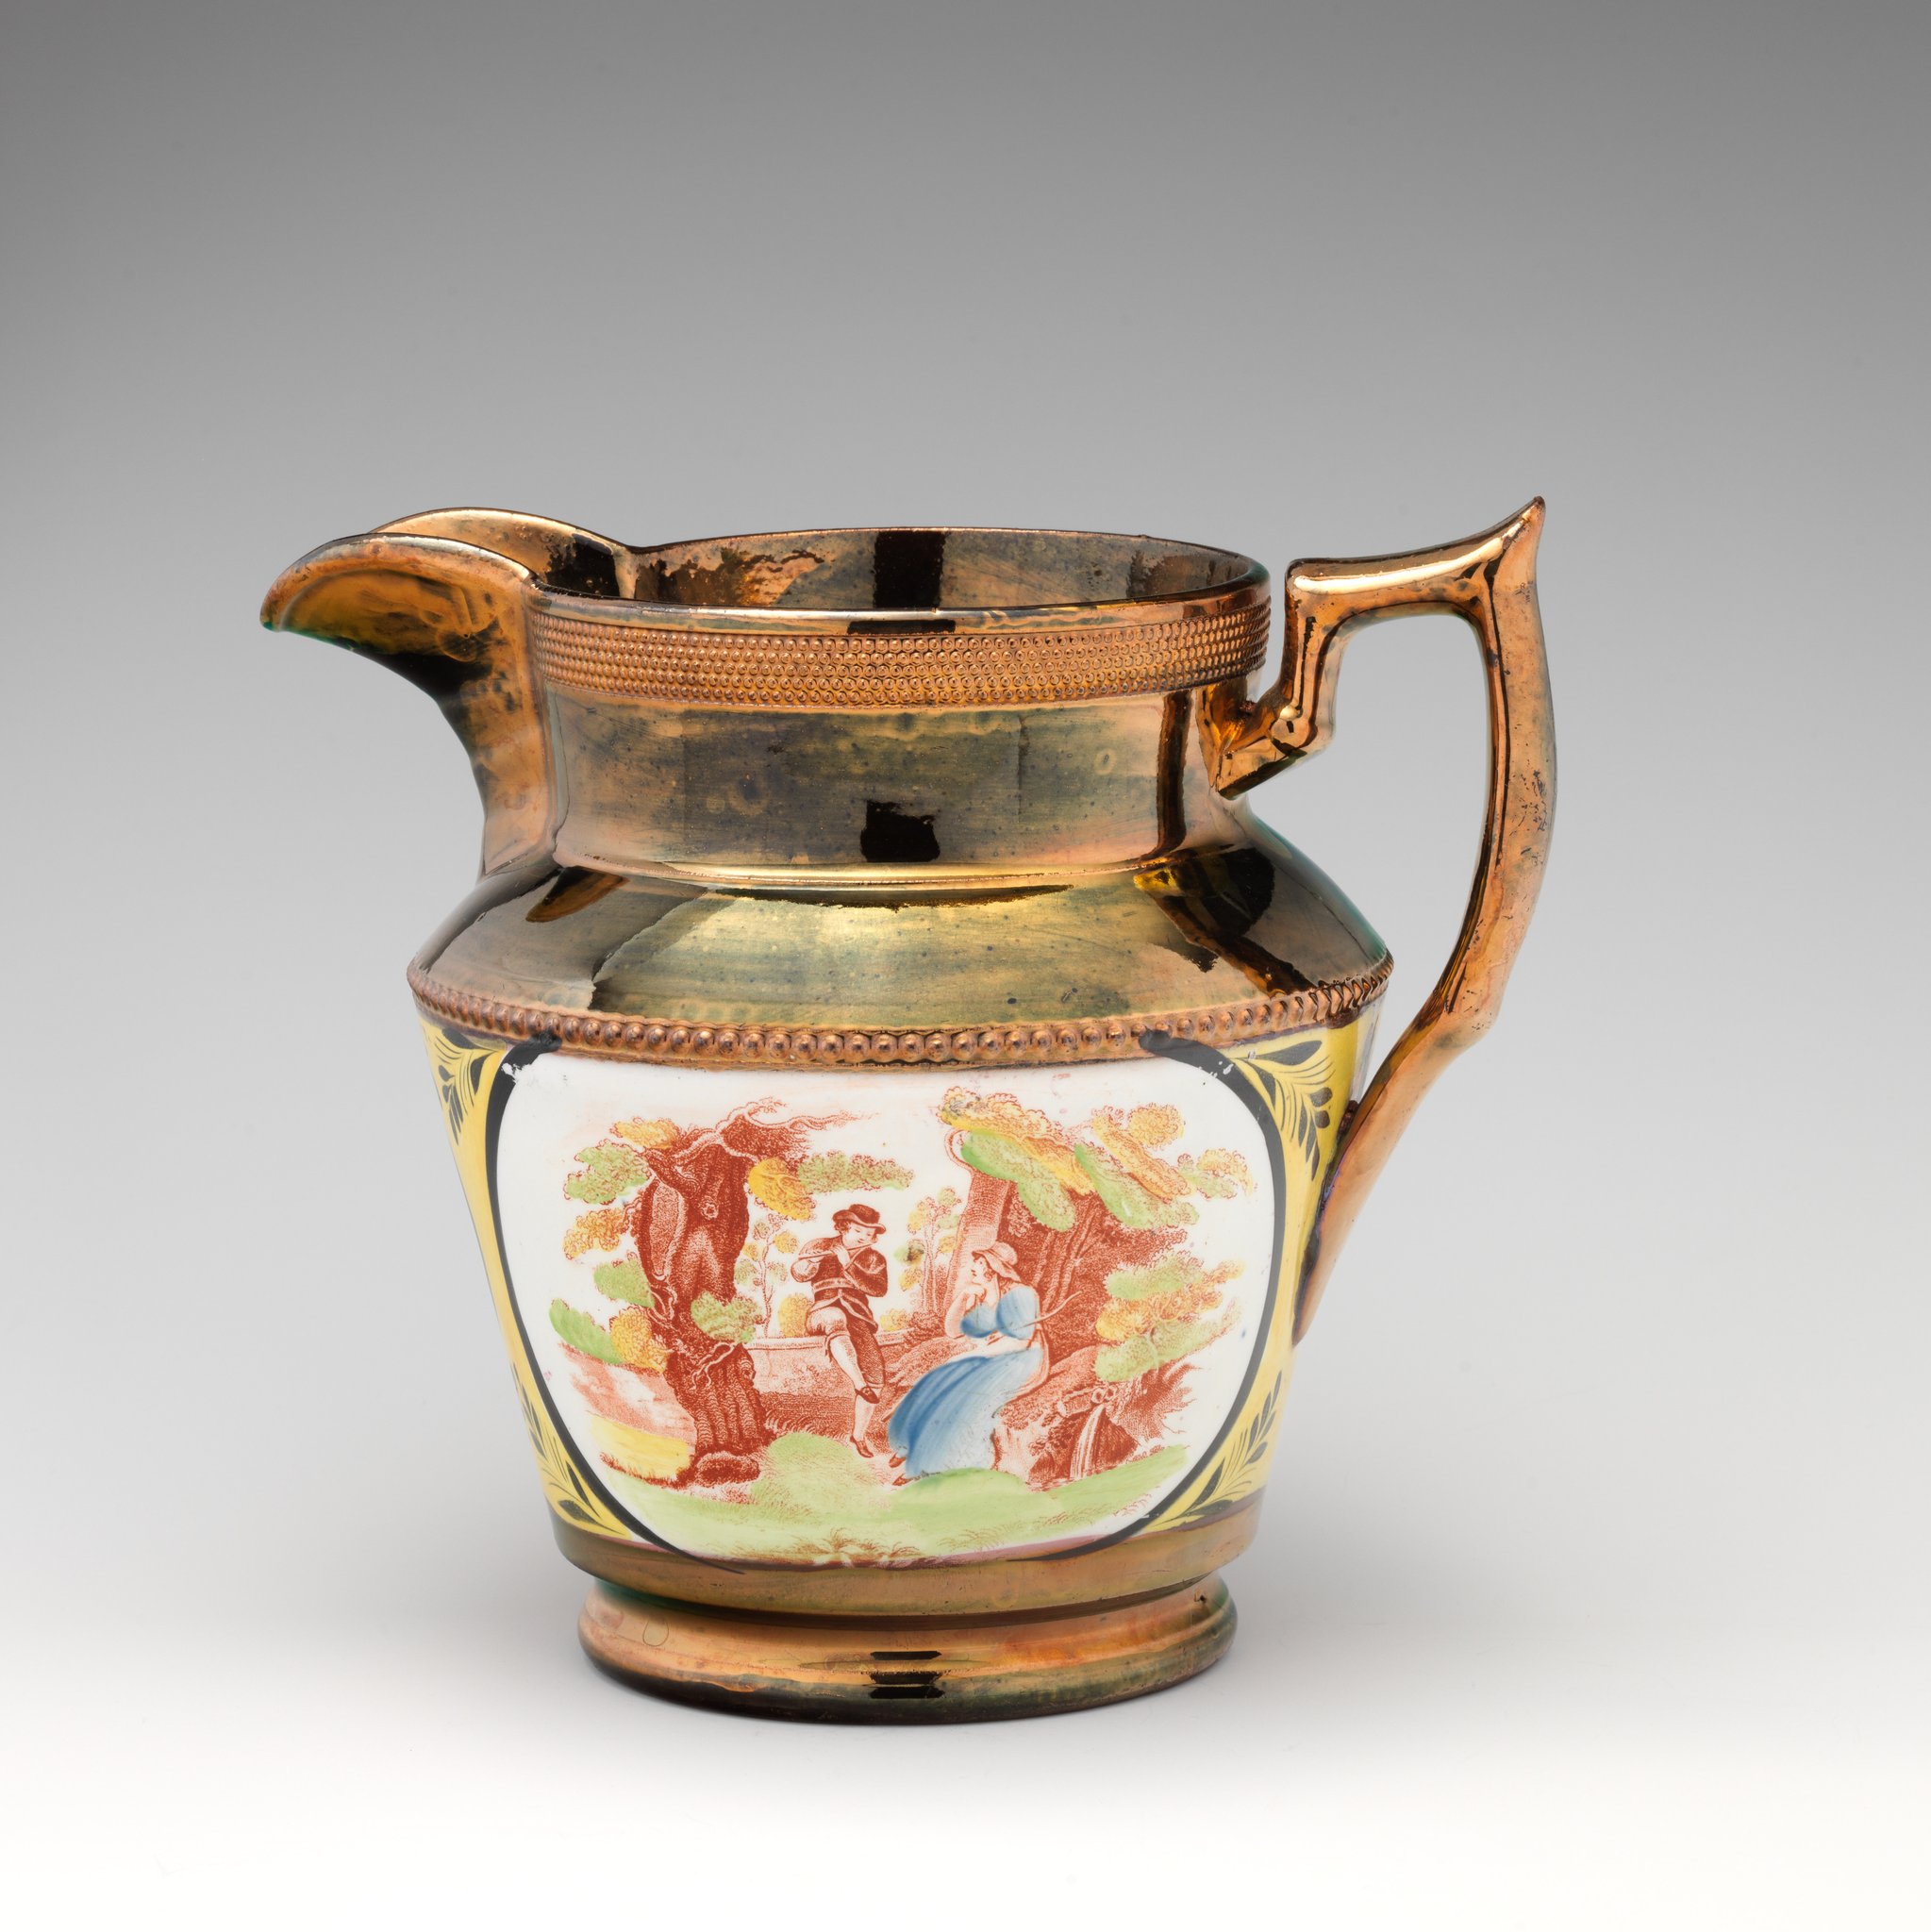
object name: pitcher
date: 1801-1900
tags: men,women,flutes